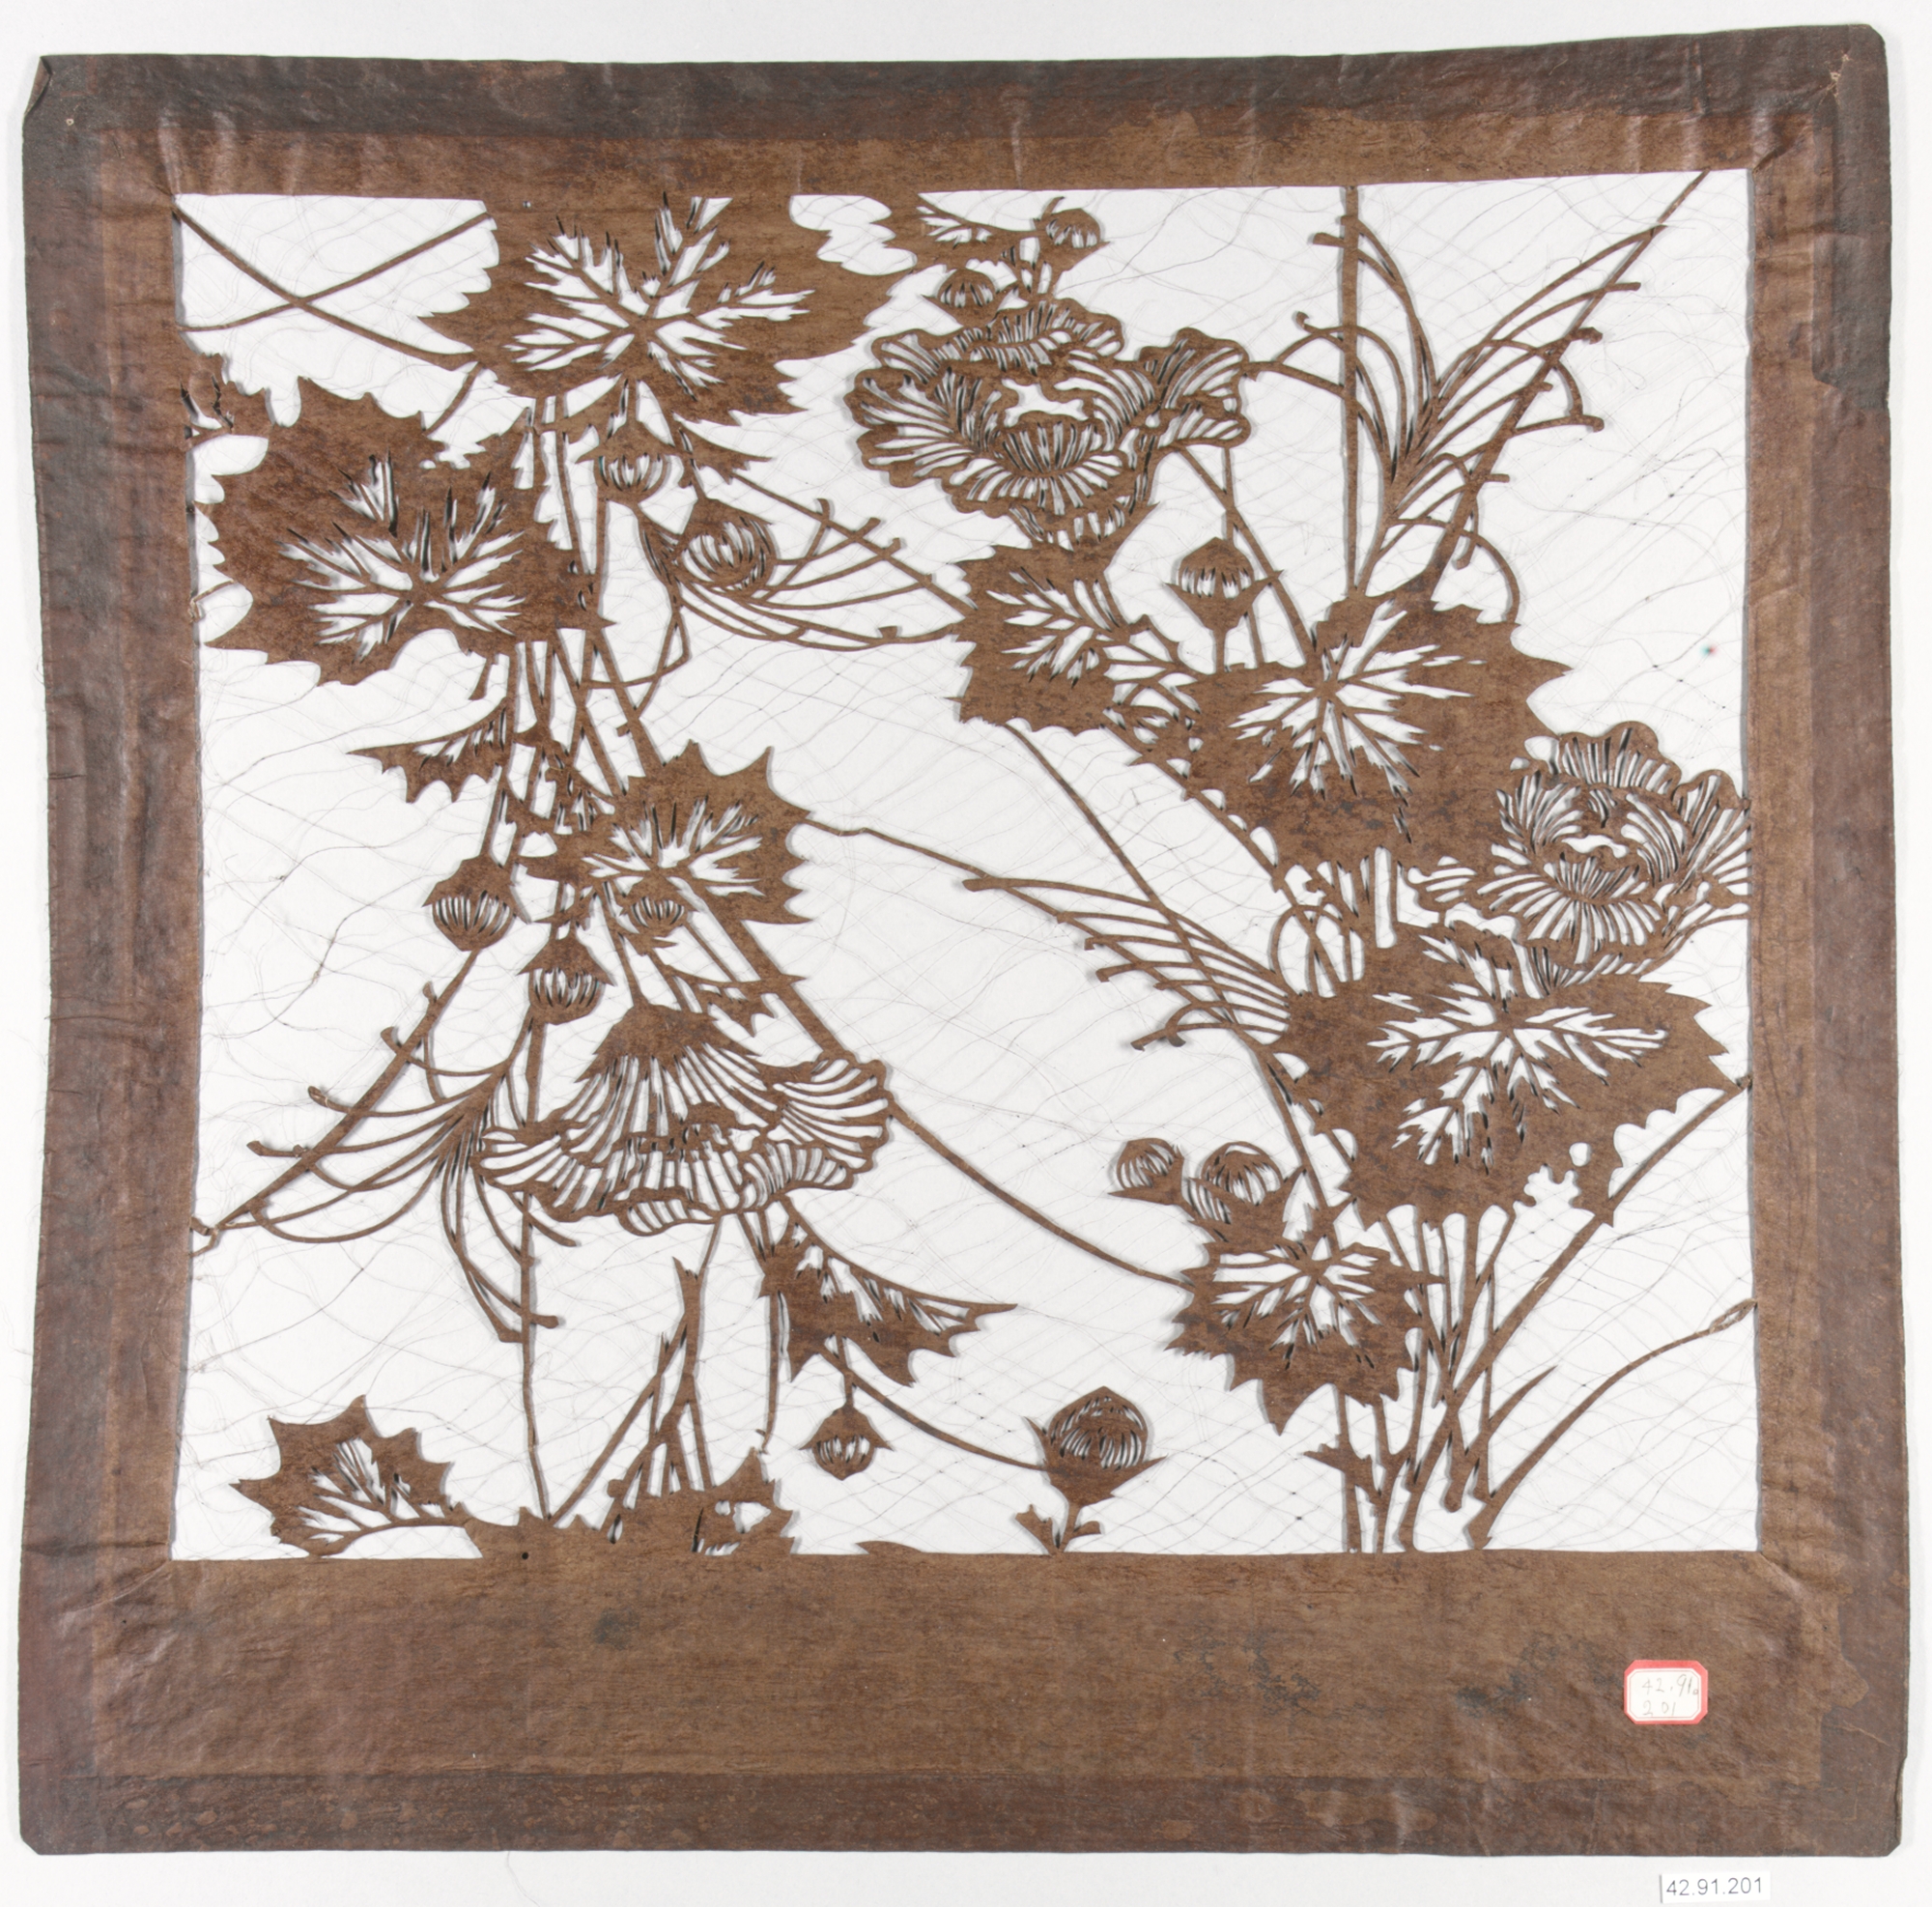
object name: stencil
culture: japanese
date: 1801-1900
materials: paper, silk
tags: flowers,leaves